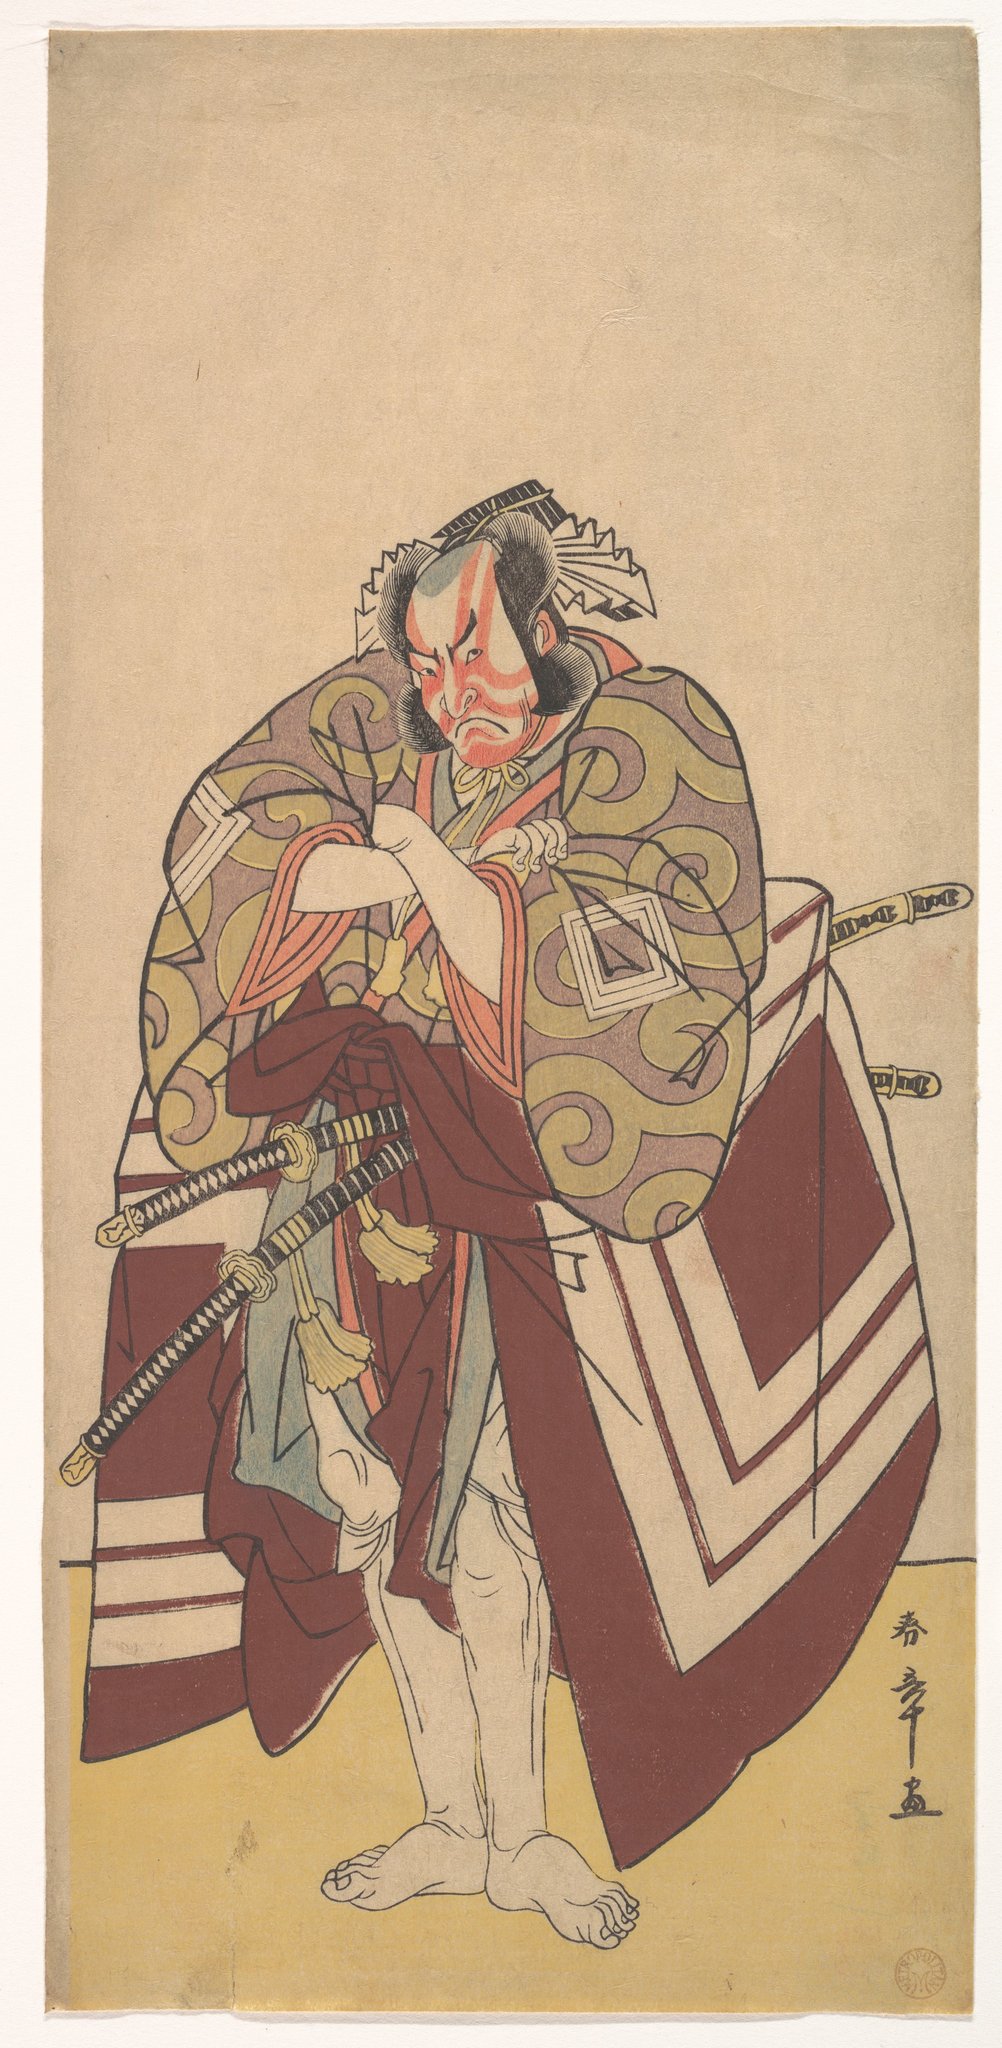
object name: woodblock print nishiki e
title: Kabuki Actor Ichikawa Danjūrō V in a Shibaraku (Stop Right There!) Role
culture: japanese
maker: katsukawa shunshō 勝川春章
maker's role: artist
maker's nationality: japanese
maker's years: 1726-1792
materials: ink, paper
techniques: nishiki e, woodblock print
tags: men,actors